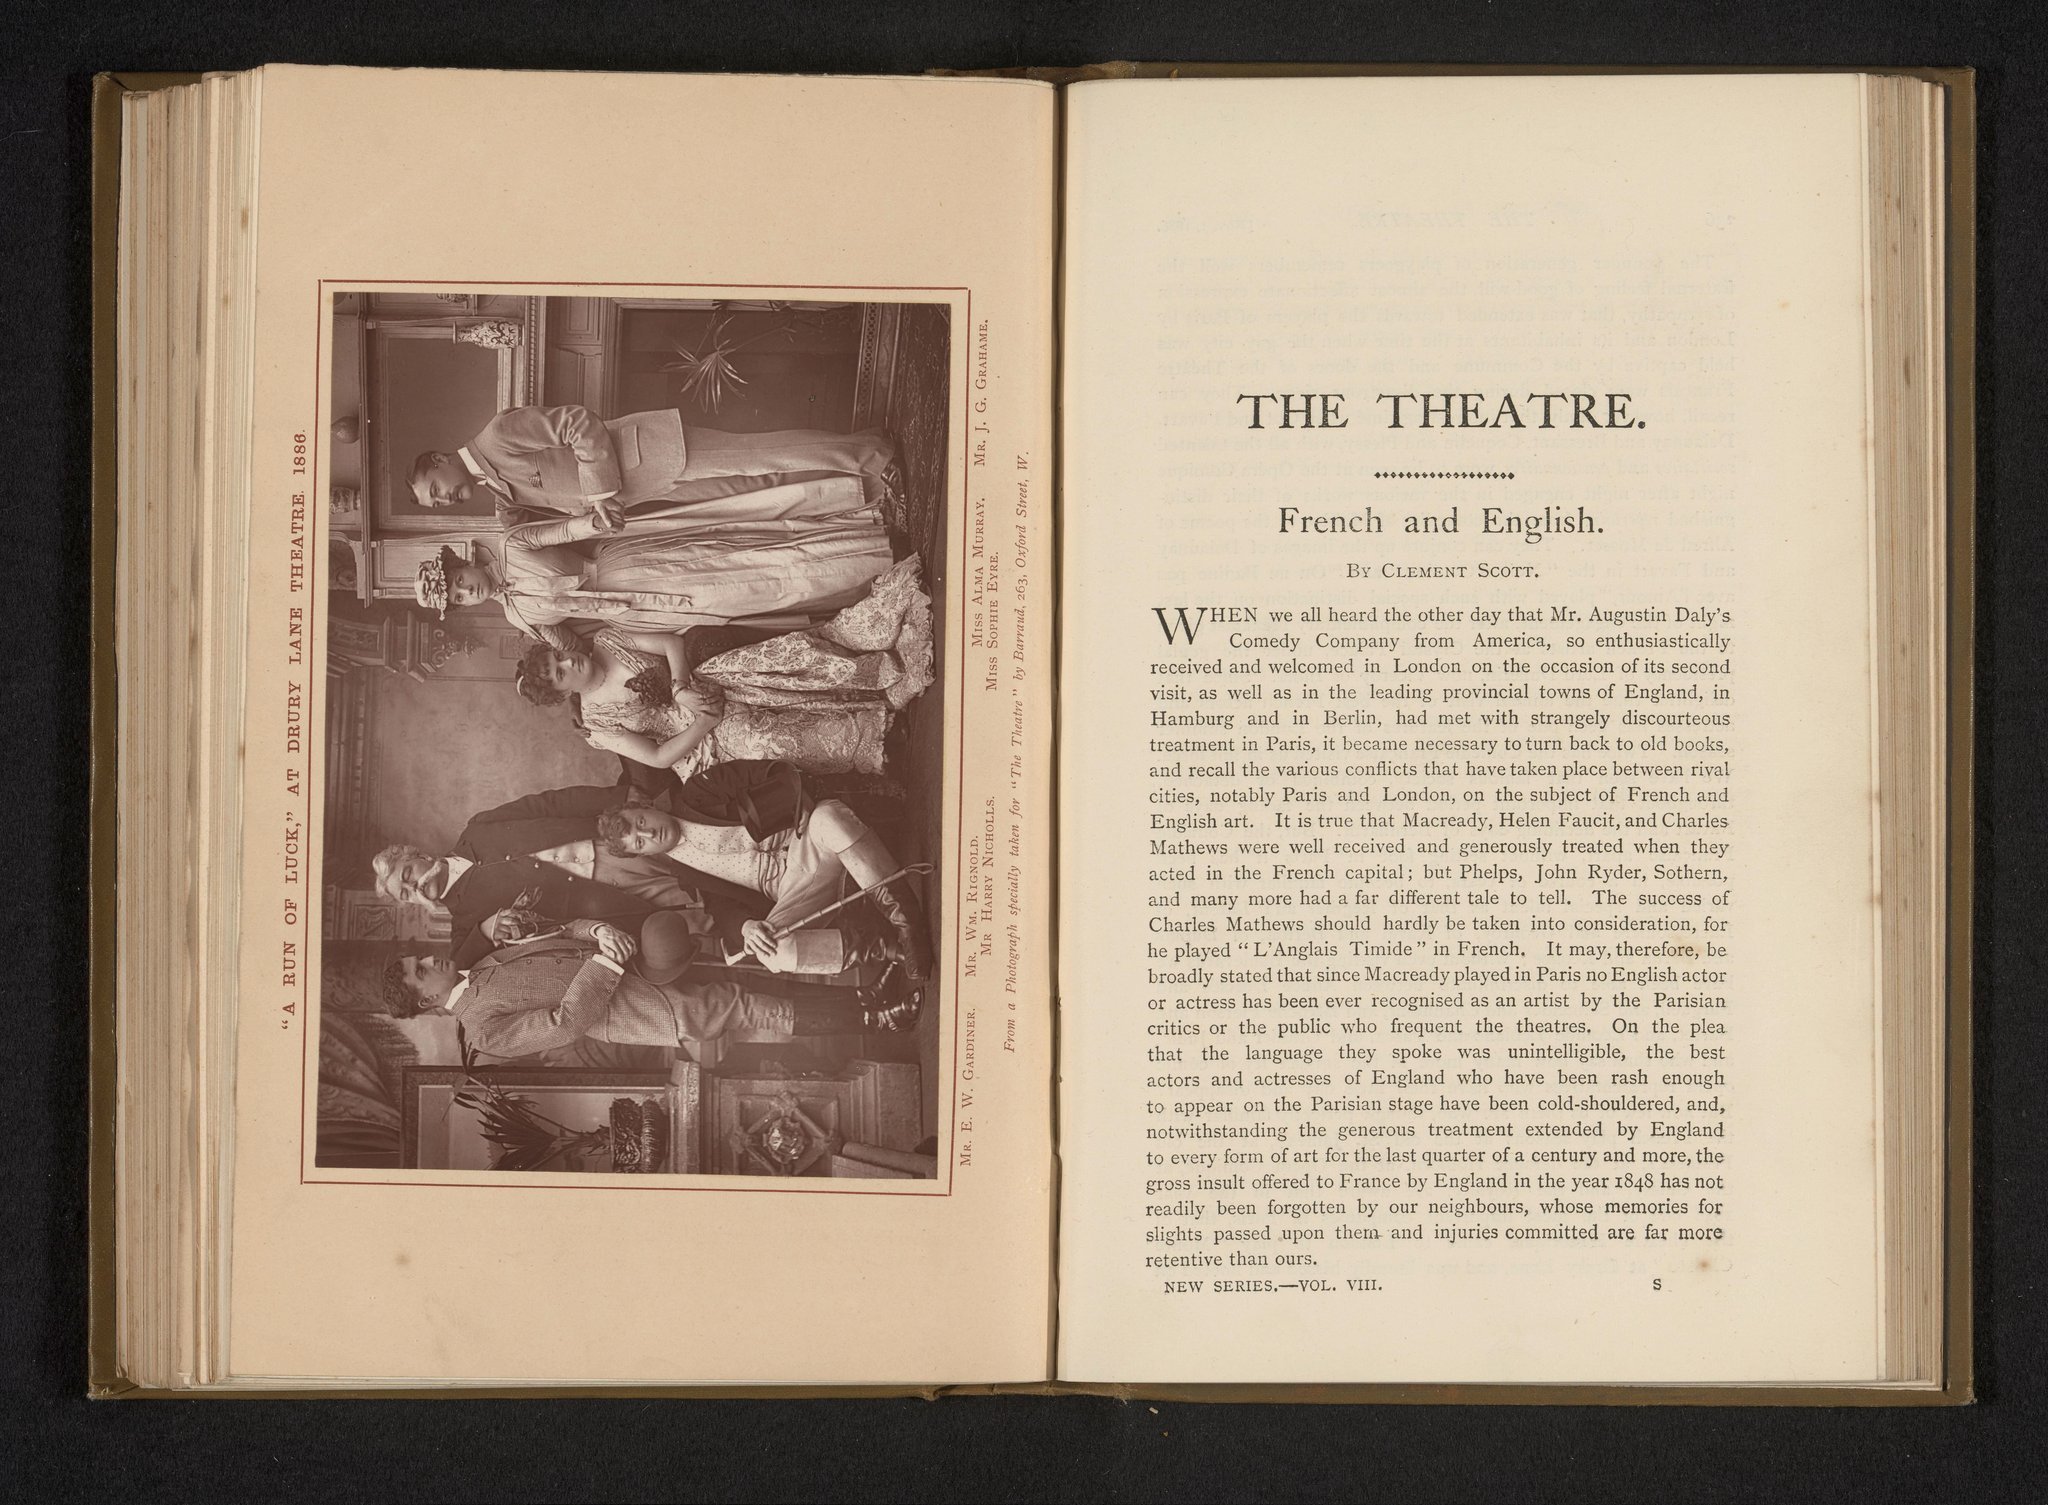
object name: photomechanical print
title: Groepsportret van de leden van The Drury Company in 'A Run of Luck'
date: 1881-1886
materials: paper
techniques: woodburytype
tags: adult woman, adult man, historical persons